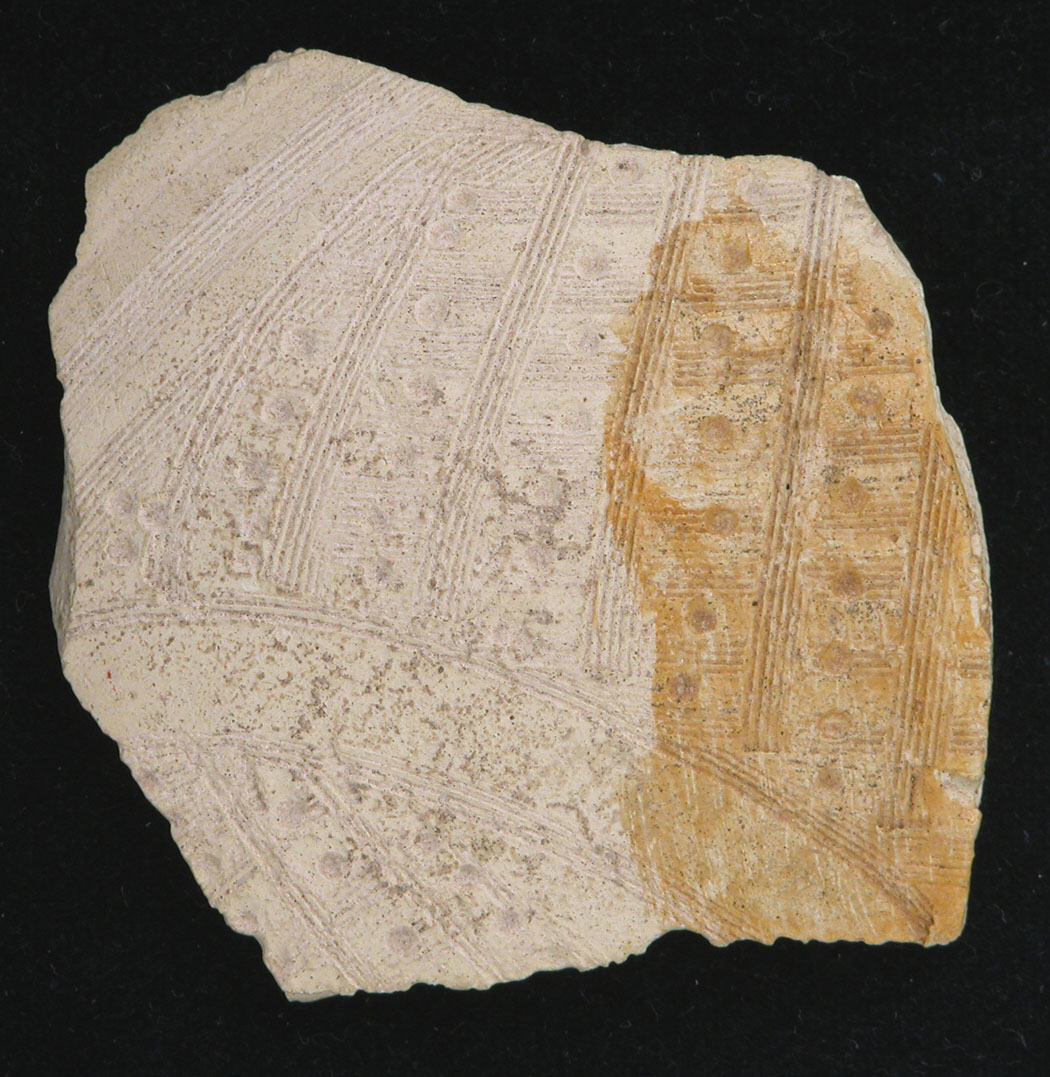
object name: fragment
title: Ceramic Fragment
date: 801-1000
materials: earthenware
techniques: incising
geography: saudi arabia